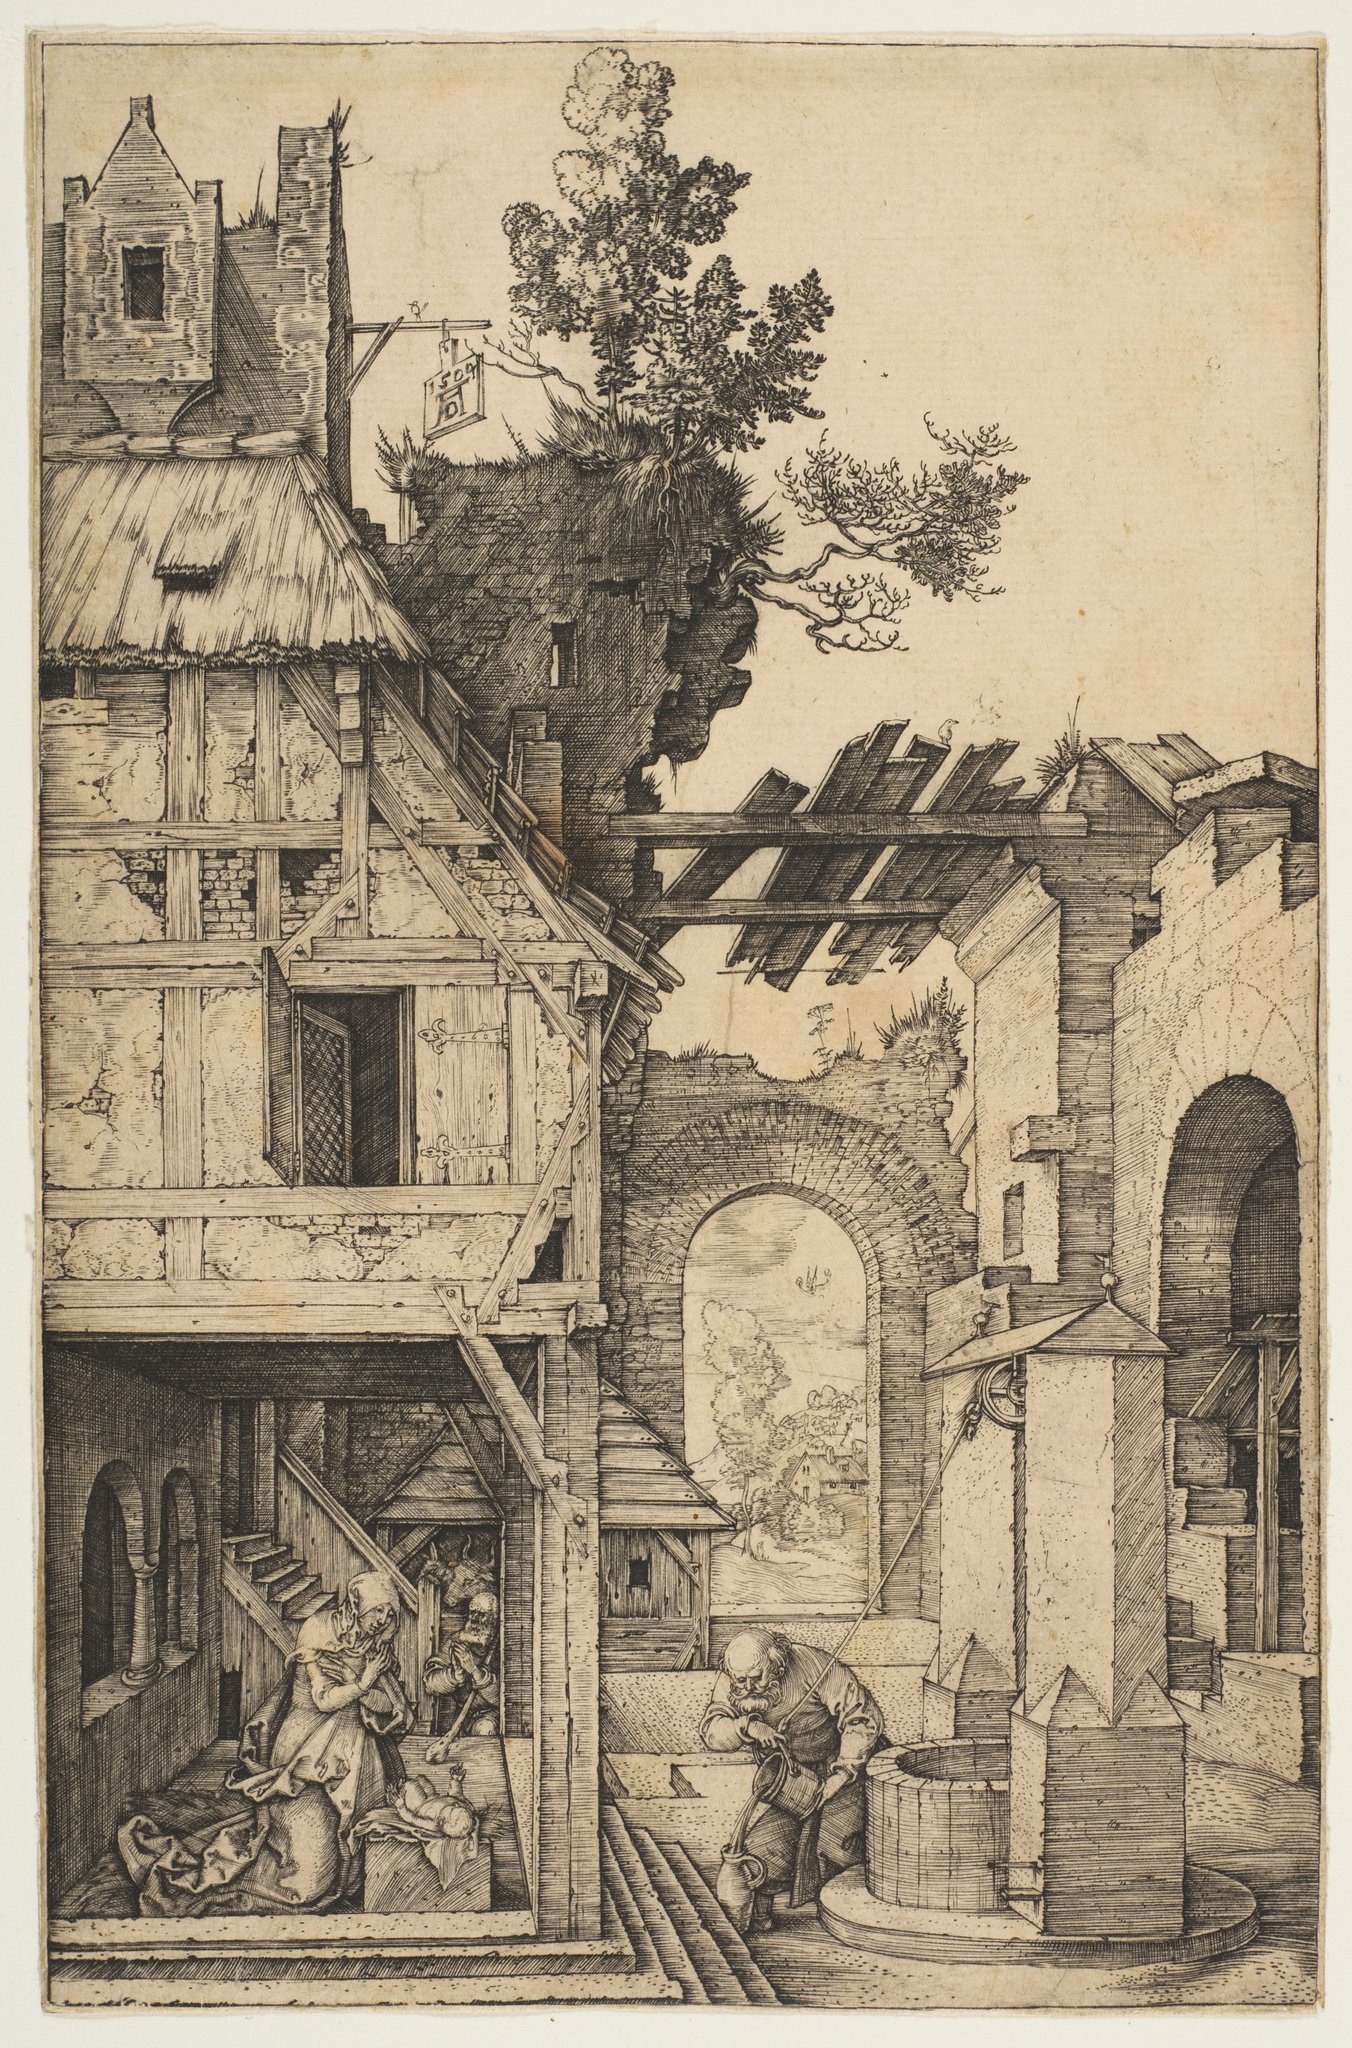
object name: print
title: The Nativity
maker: albrecht dürer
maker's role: artist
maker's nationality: german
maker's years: 1471-1528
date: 1504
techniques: engraving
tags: wells,men,women,virgin mary,jesus,nativity